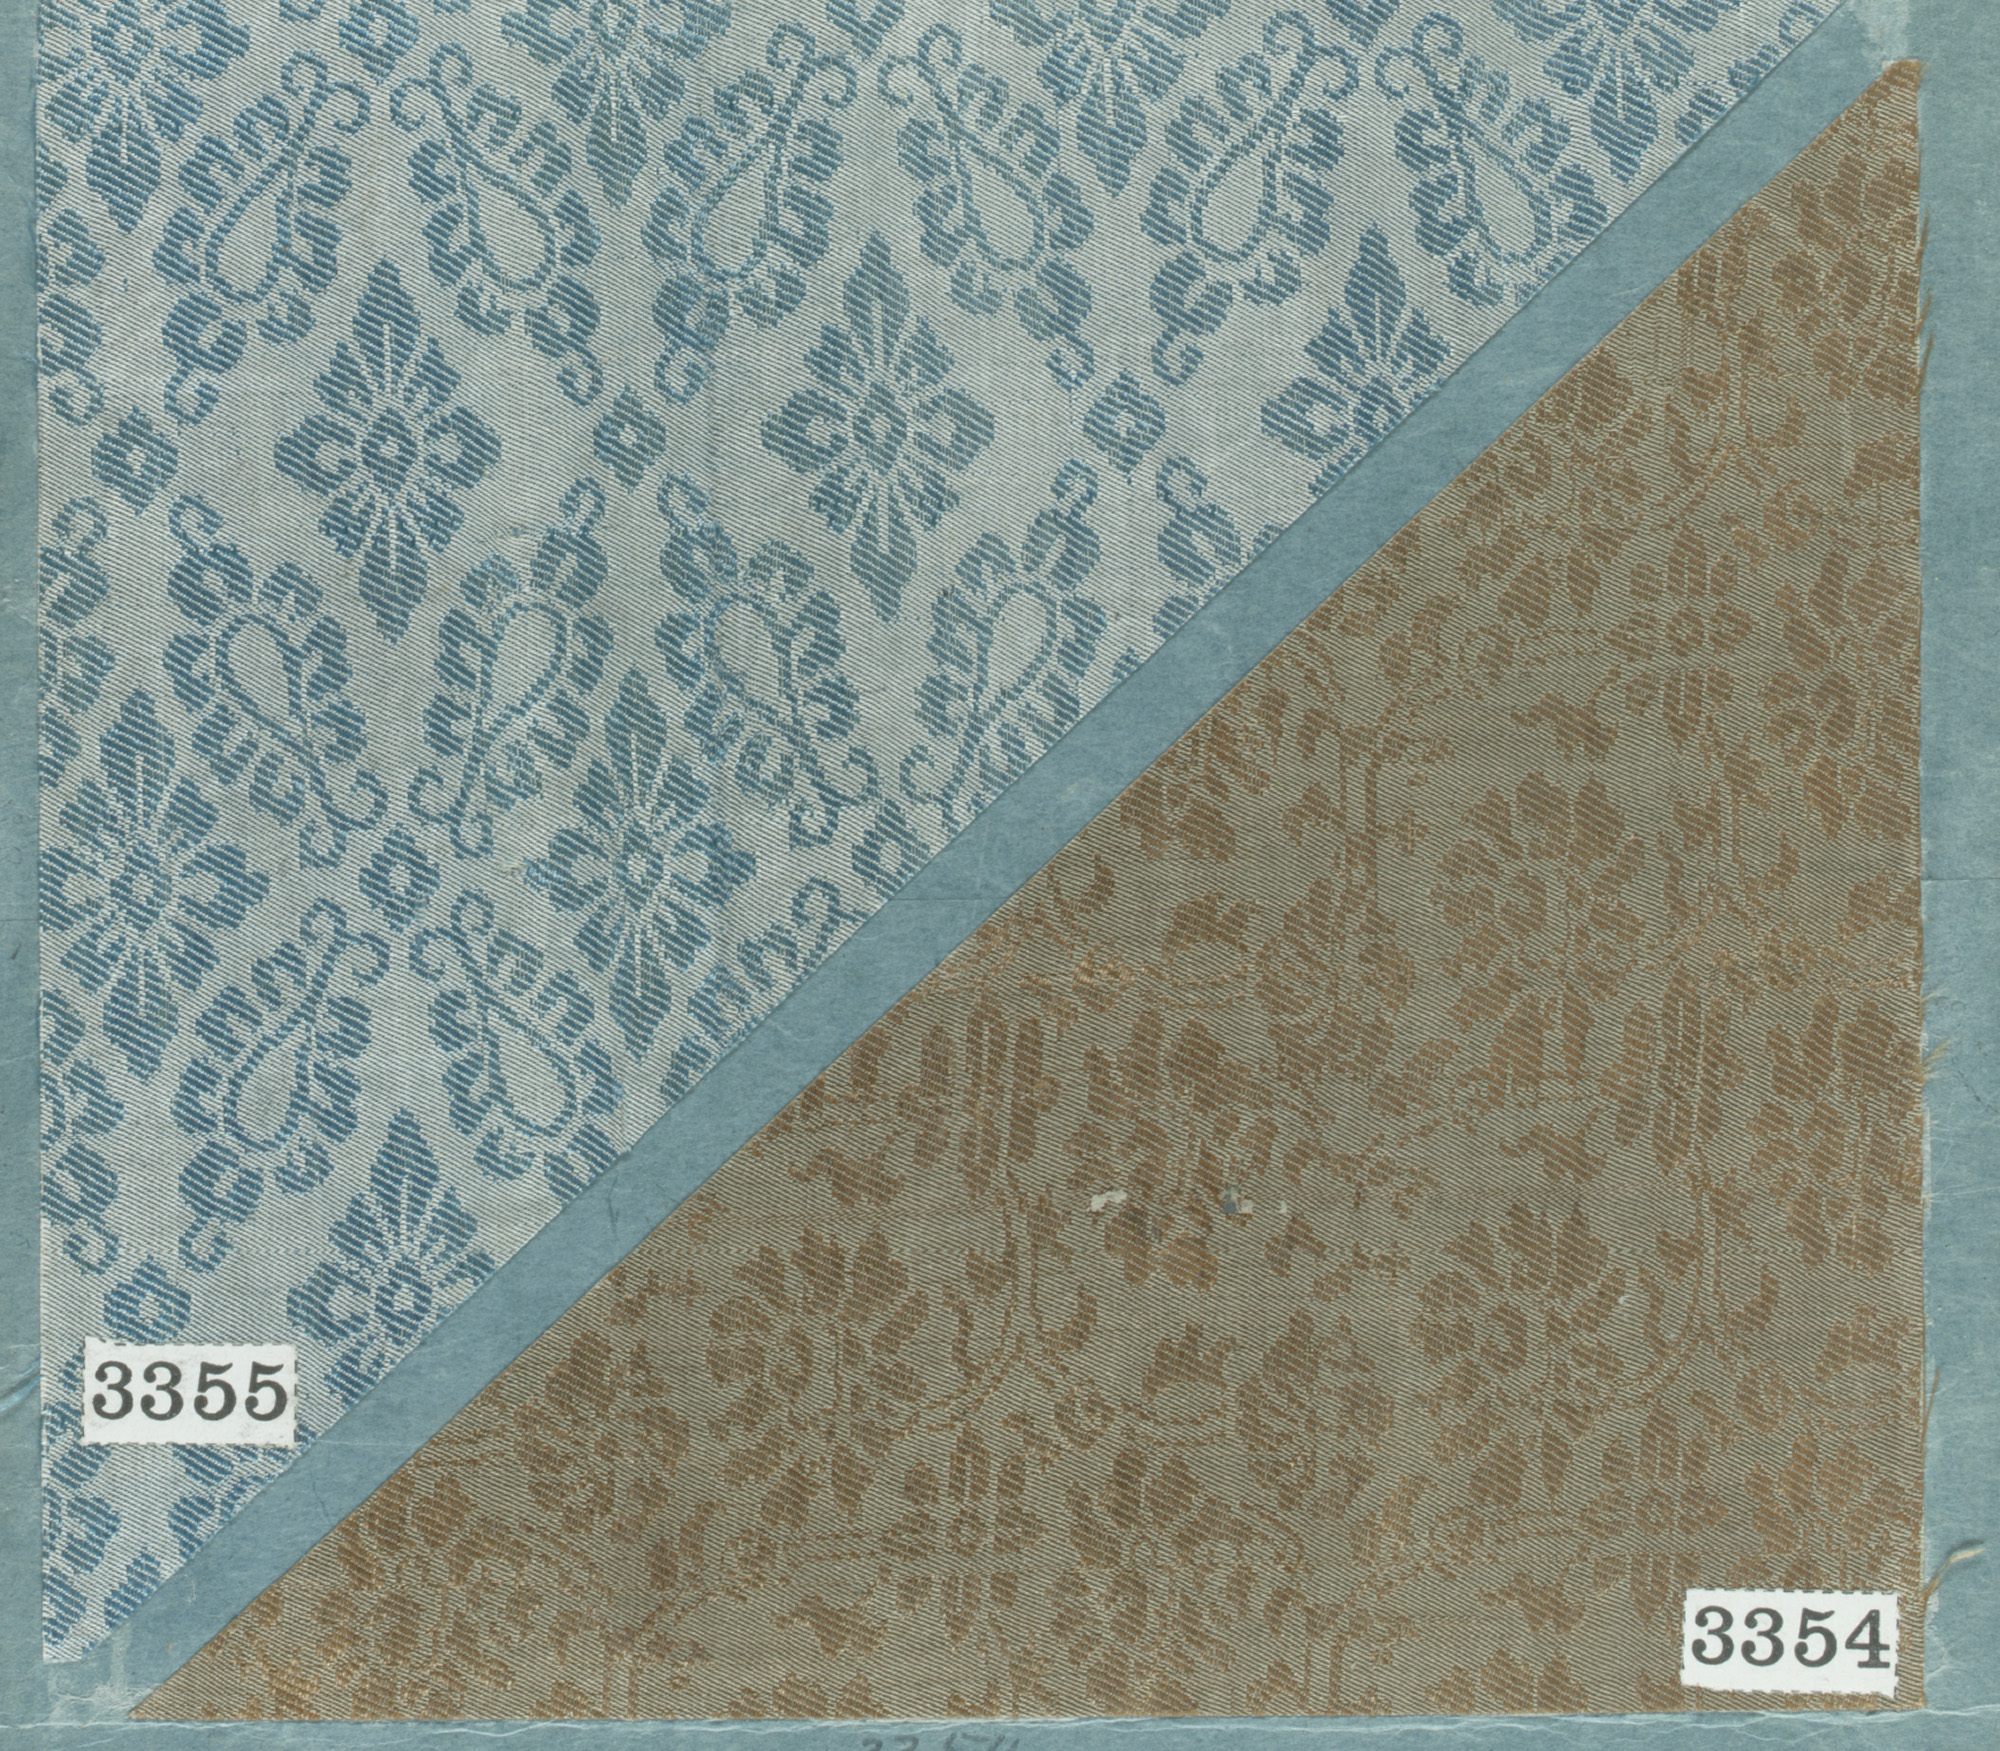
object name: textile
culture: japanese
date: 1801-1900